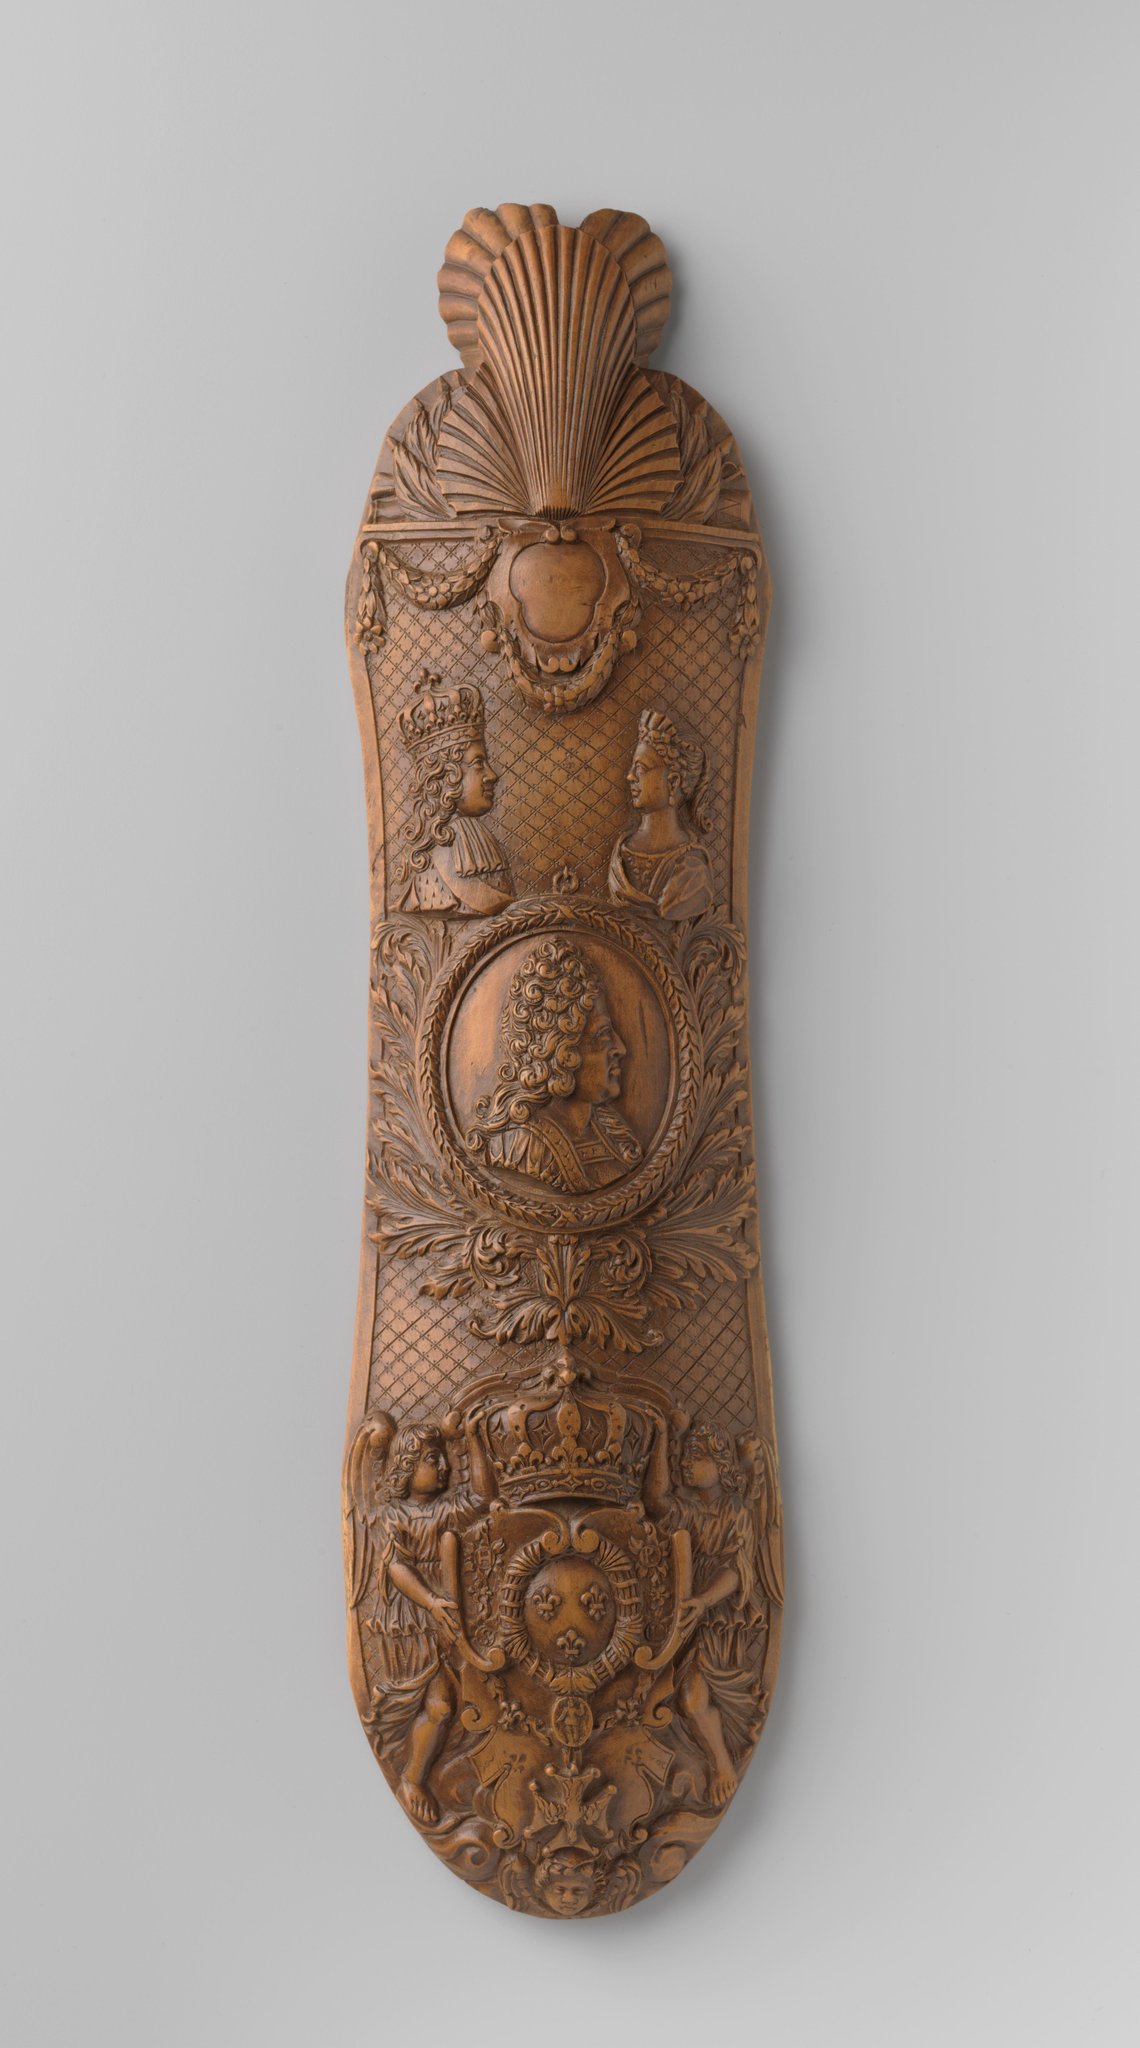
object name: grater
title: Rasp van palmhout met medaillonportret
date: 1700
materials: wood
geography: france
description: Rasp van palmhout. De rugzijde in laag reliëf versierd met een medaillonportret van Lodewijk XIV (?) waarboven toegewende profielportretten van een jeugdig vorstenpaar. Onderaan het Franse koningswapen omgeven door ketenen van de orde van St. Michel en van St. Esprit vastgehouden door twee engelen. In de ketenen de letters H.R.S.L. Bovenaan een cartouche met bloem- en blad-guirlandes. Hierboven een schelpvormig palmet-motief omgeven door tropheëen. de ijzeren rasp is omgeven door een bladrand met aan de bovenzijde twee toegewende vogels; onderaan het wapen van een bastaardtak der Bourbons.